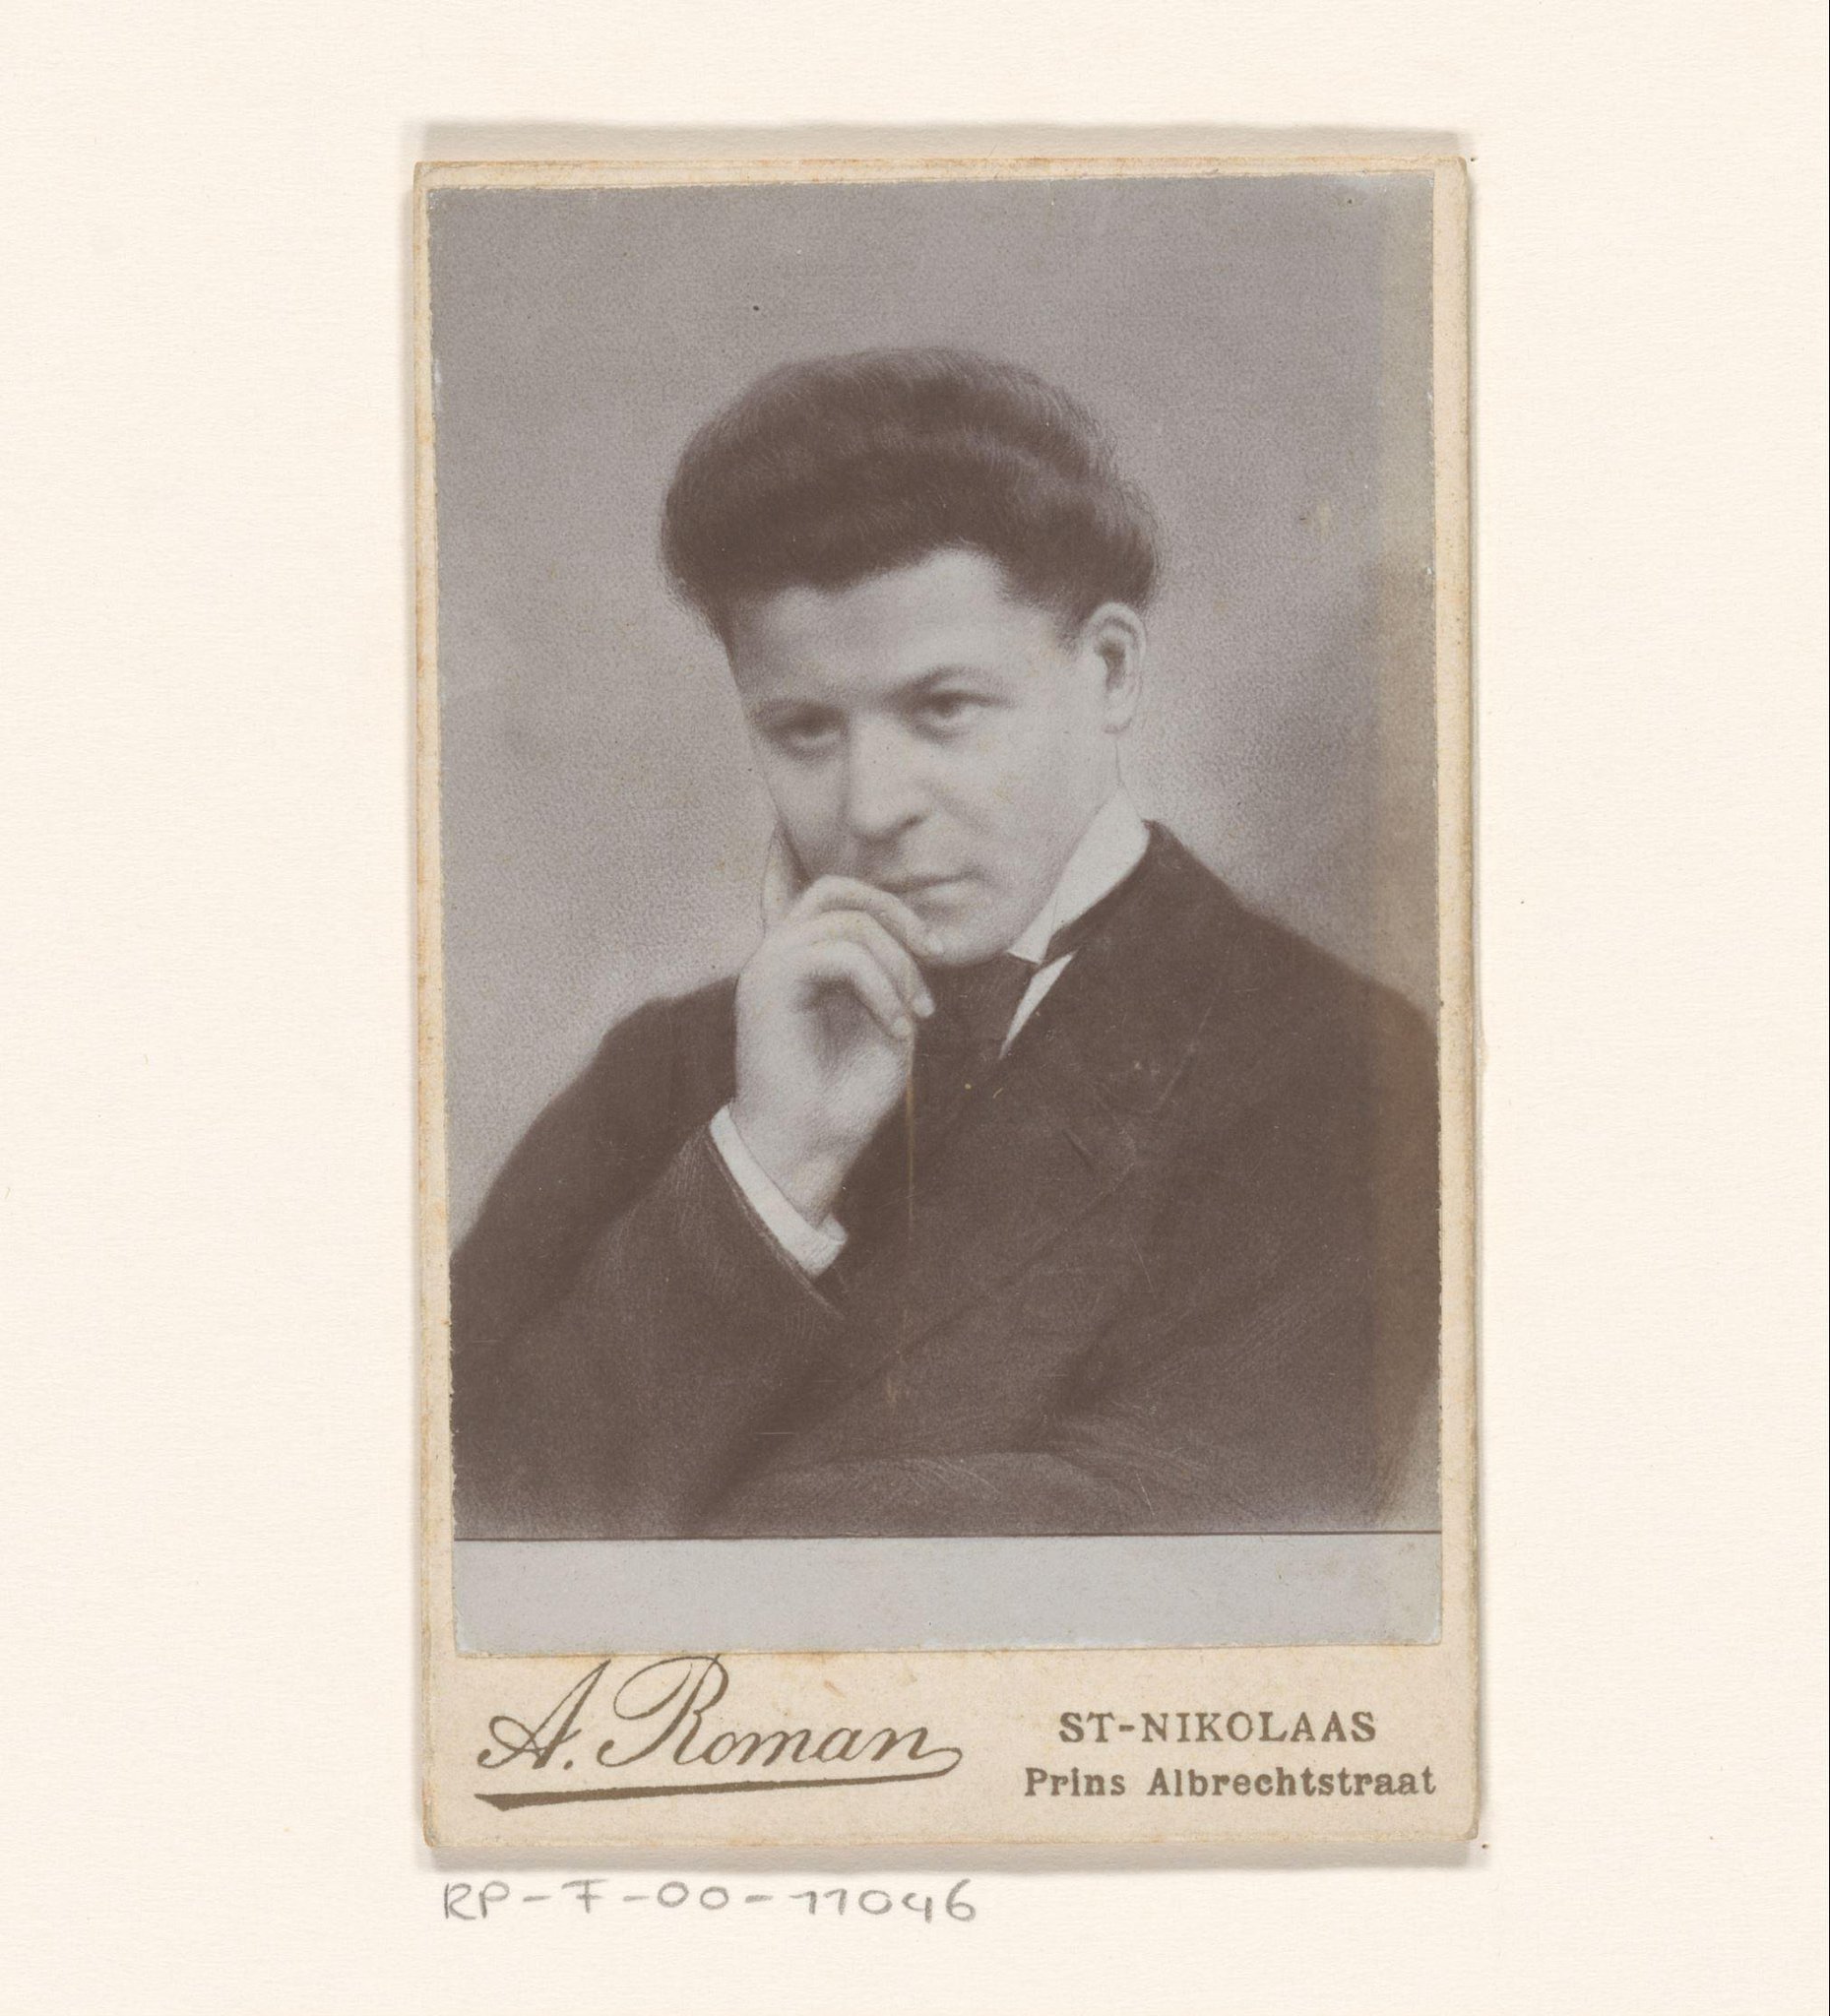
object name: photograph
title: Portret van een onbekende man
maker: a. roman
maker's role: fotograaf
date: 1880-1930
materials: cardboard, photographic support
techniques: collodion silver print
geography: sint-niklaas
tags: historical persons not known by name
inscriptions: :, collector's mark: Lugt 2228a, inscription: ‘A. Roman/ ST-NIKOLAAS/ Prins Albrechtstraat’